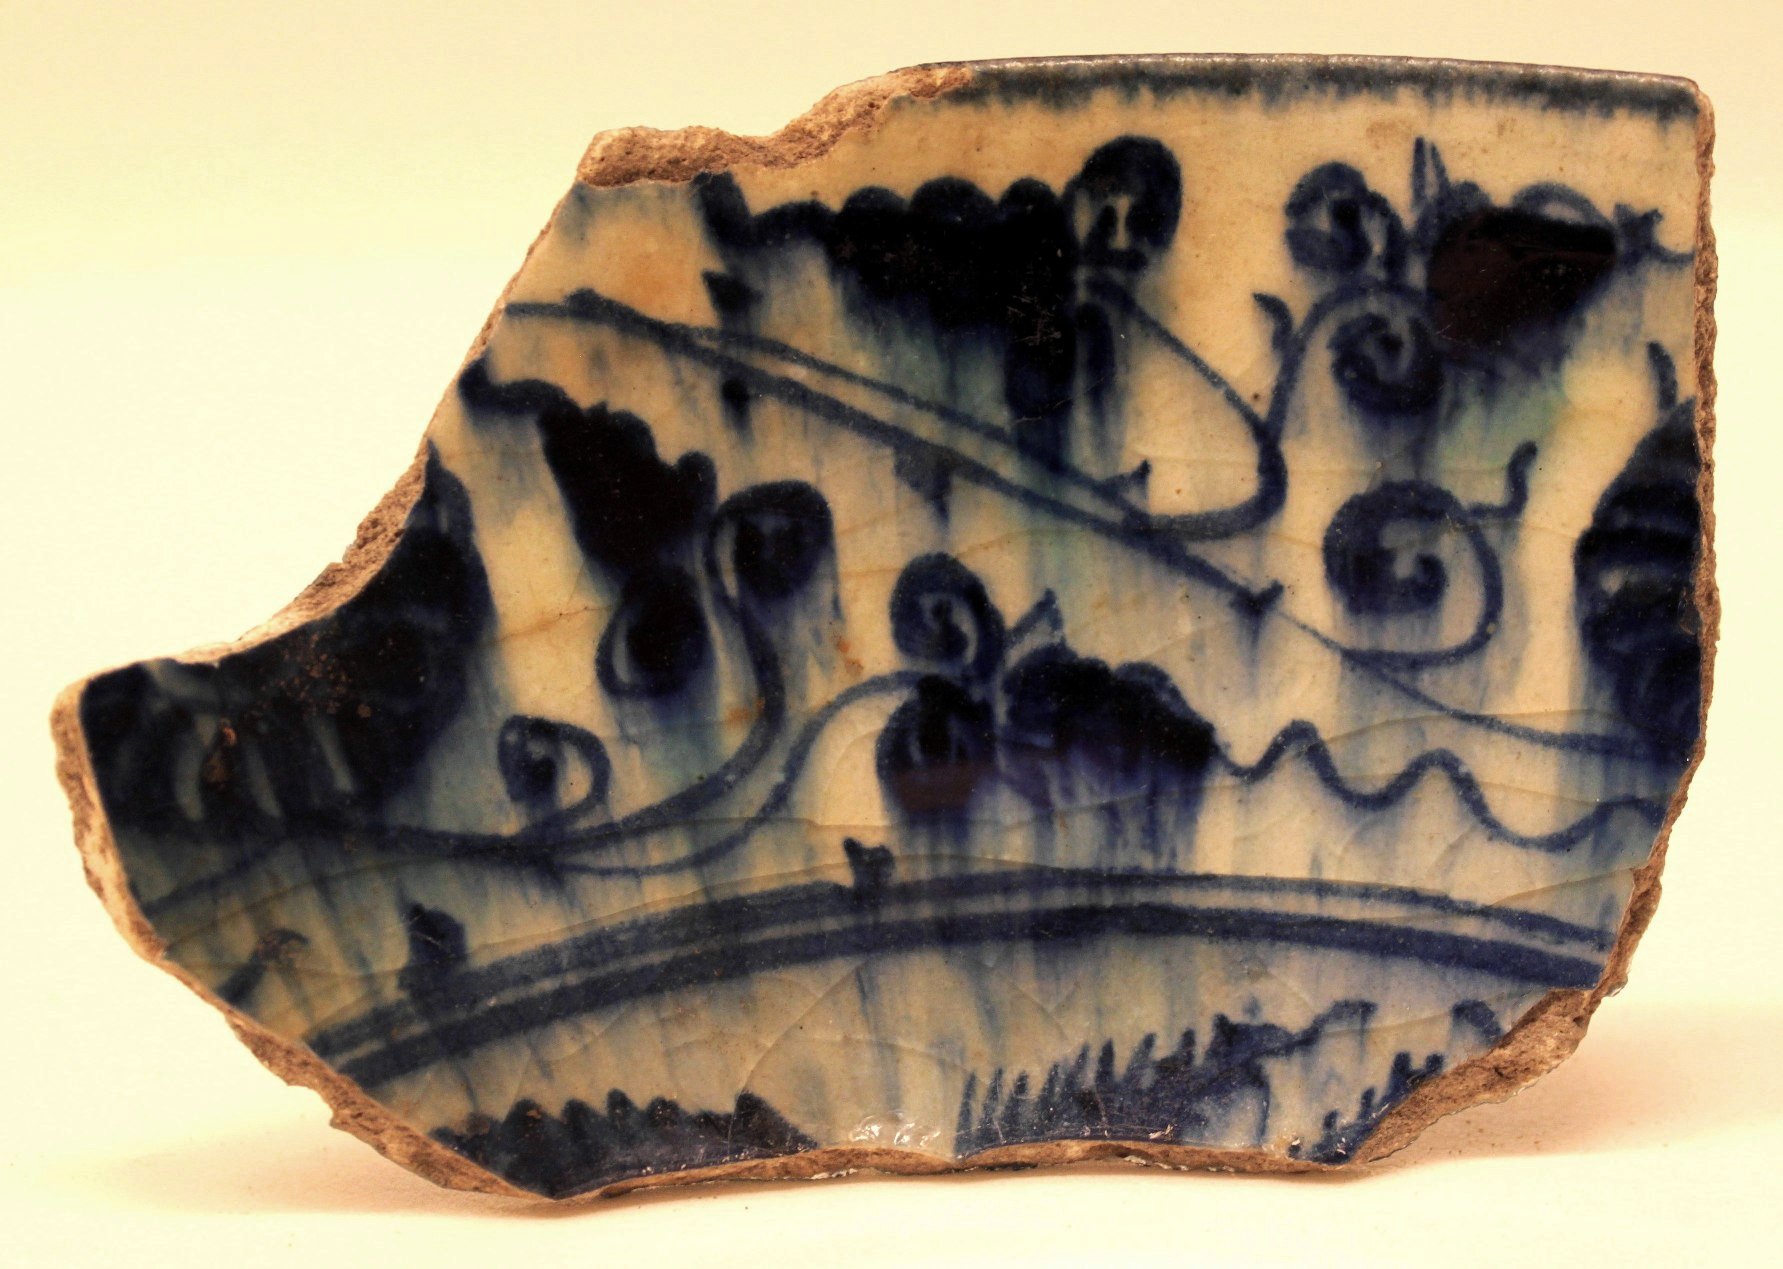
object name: ceramic fragment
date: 1401-1600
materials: glaze, stonepaste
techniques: painting, underglaze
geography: syria